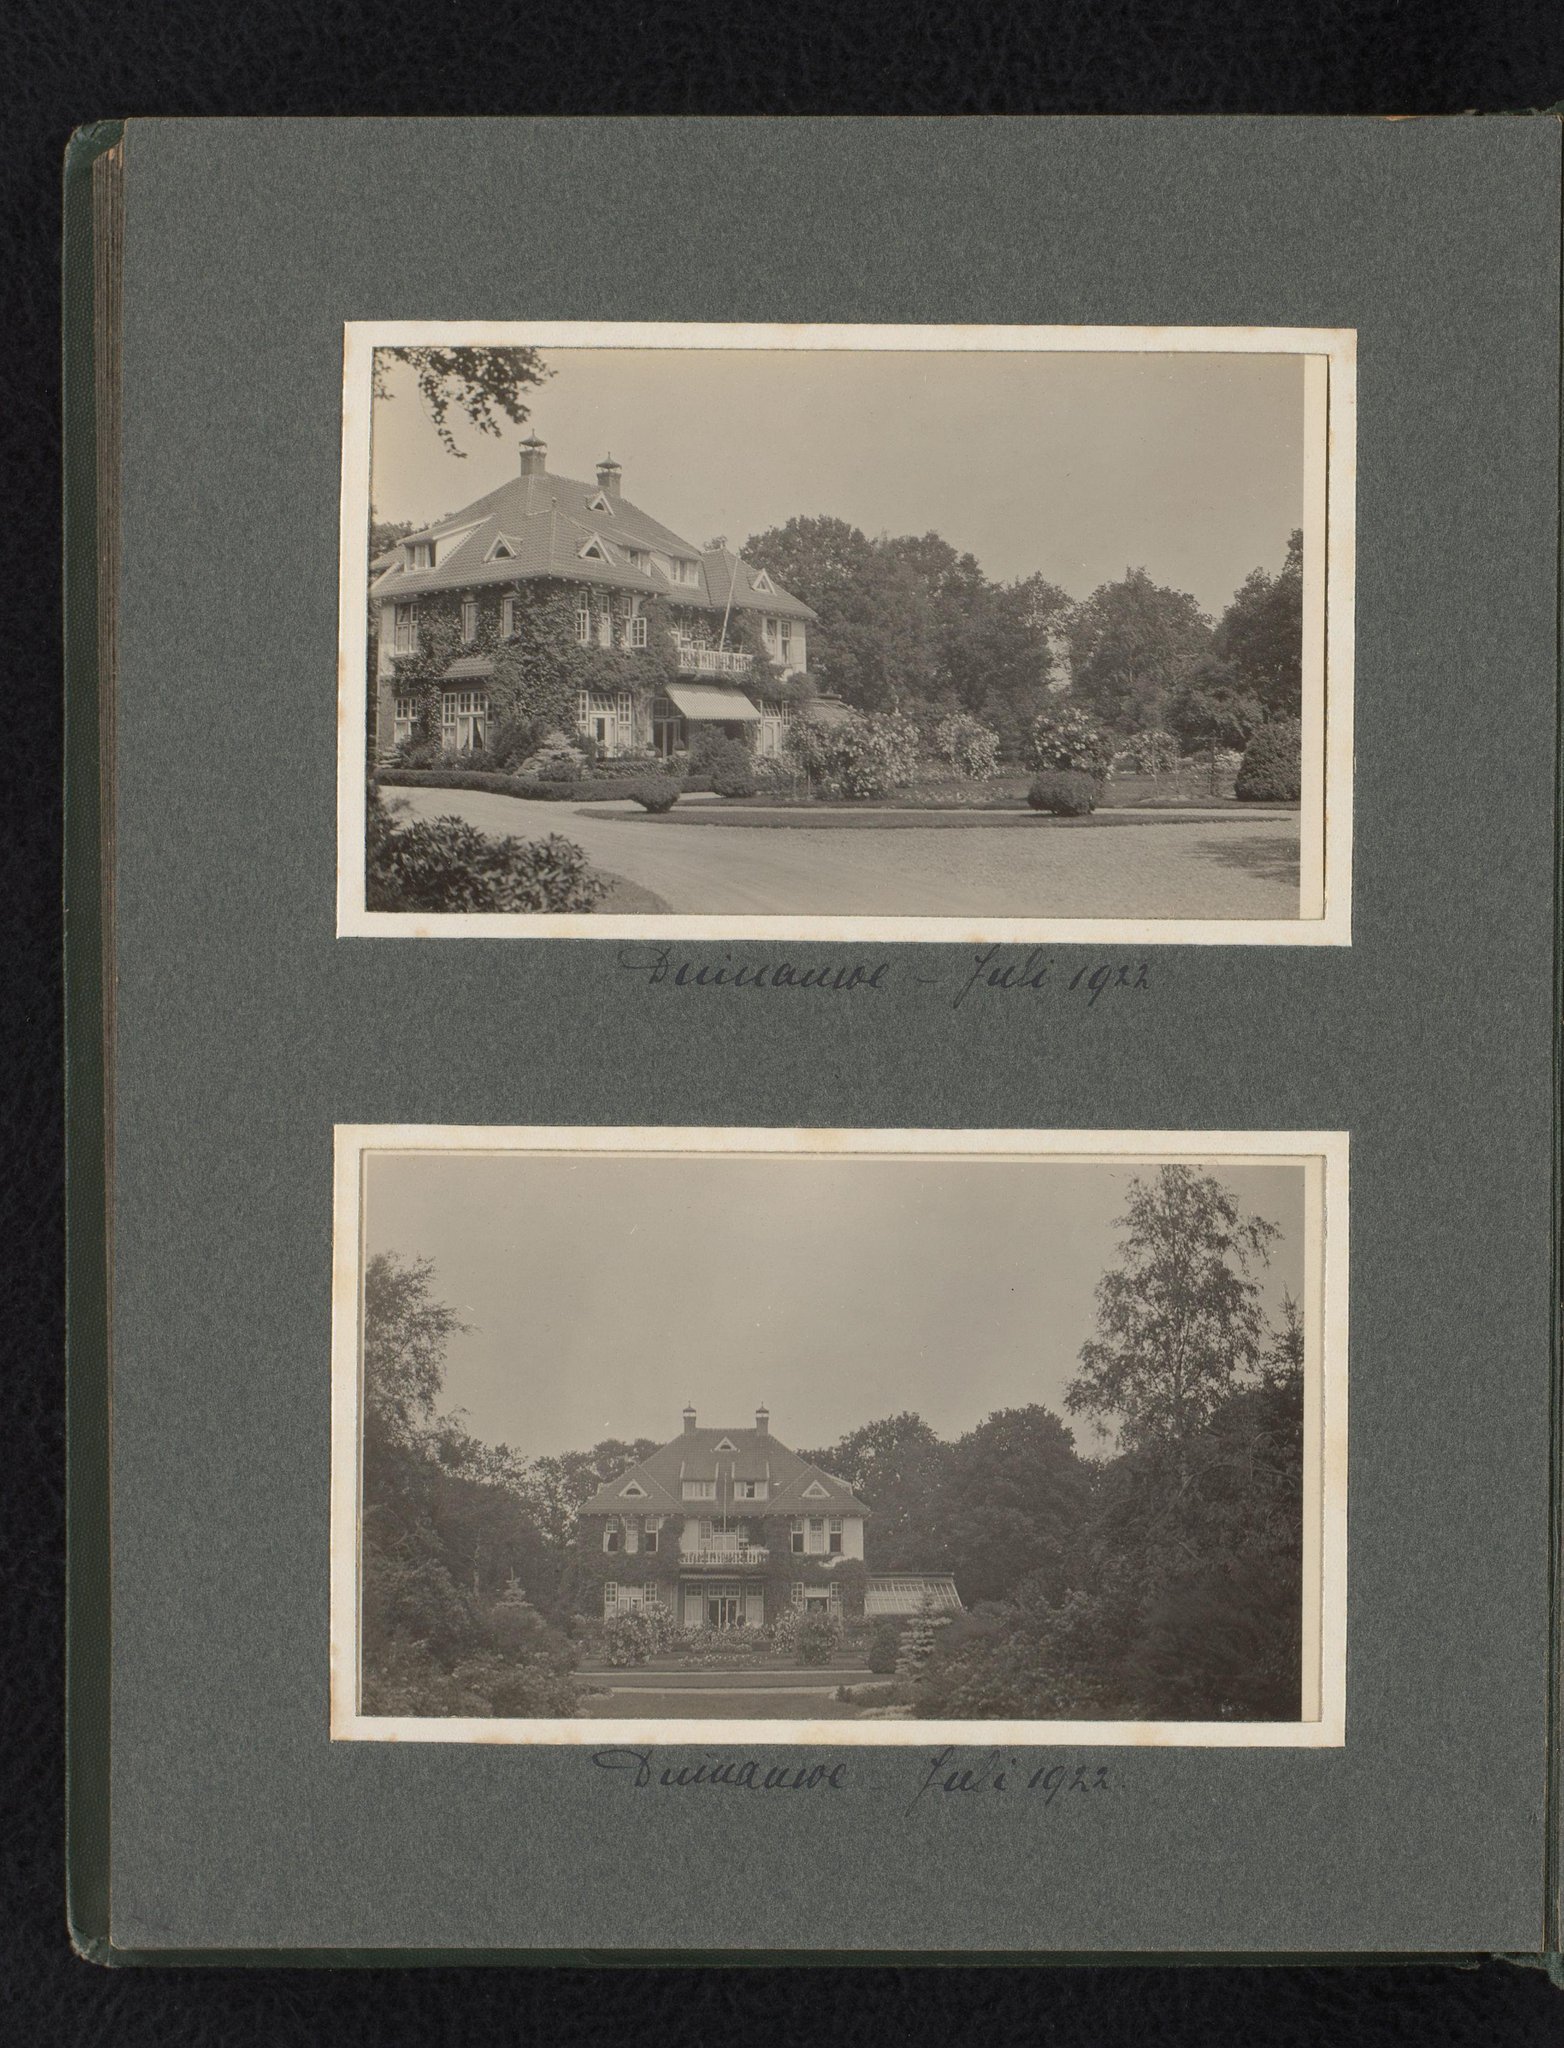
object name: album leaf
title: Twee foto's van landhuis Duinauwe in Wassenaar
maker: hendrik herman van den berg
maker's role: amateurfotograaf, jurist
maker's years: 1875-1944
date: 1907-1922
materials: paper, cardboard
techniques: gelatin silver print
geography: wassenaar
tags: rural housing, e.g. country-house, villa, cottage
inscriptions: caption: ‘Duinauwe Juli 1922/ Duinauwe Juli 1922’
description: Deze foto's maken deel uit van een album.